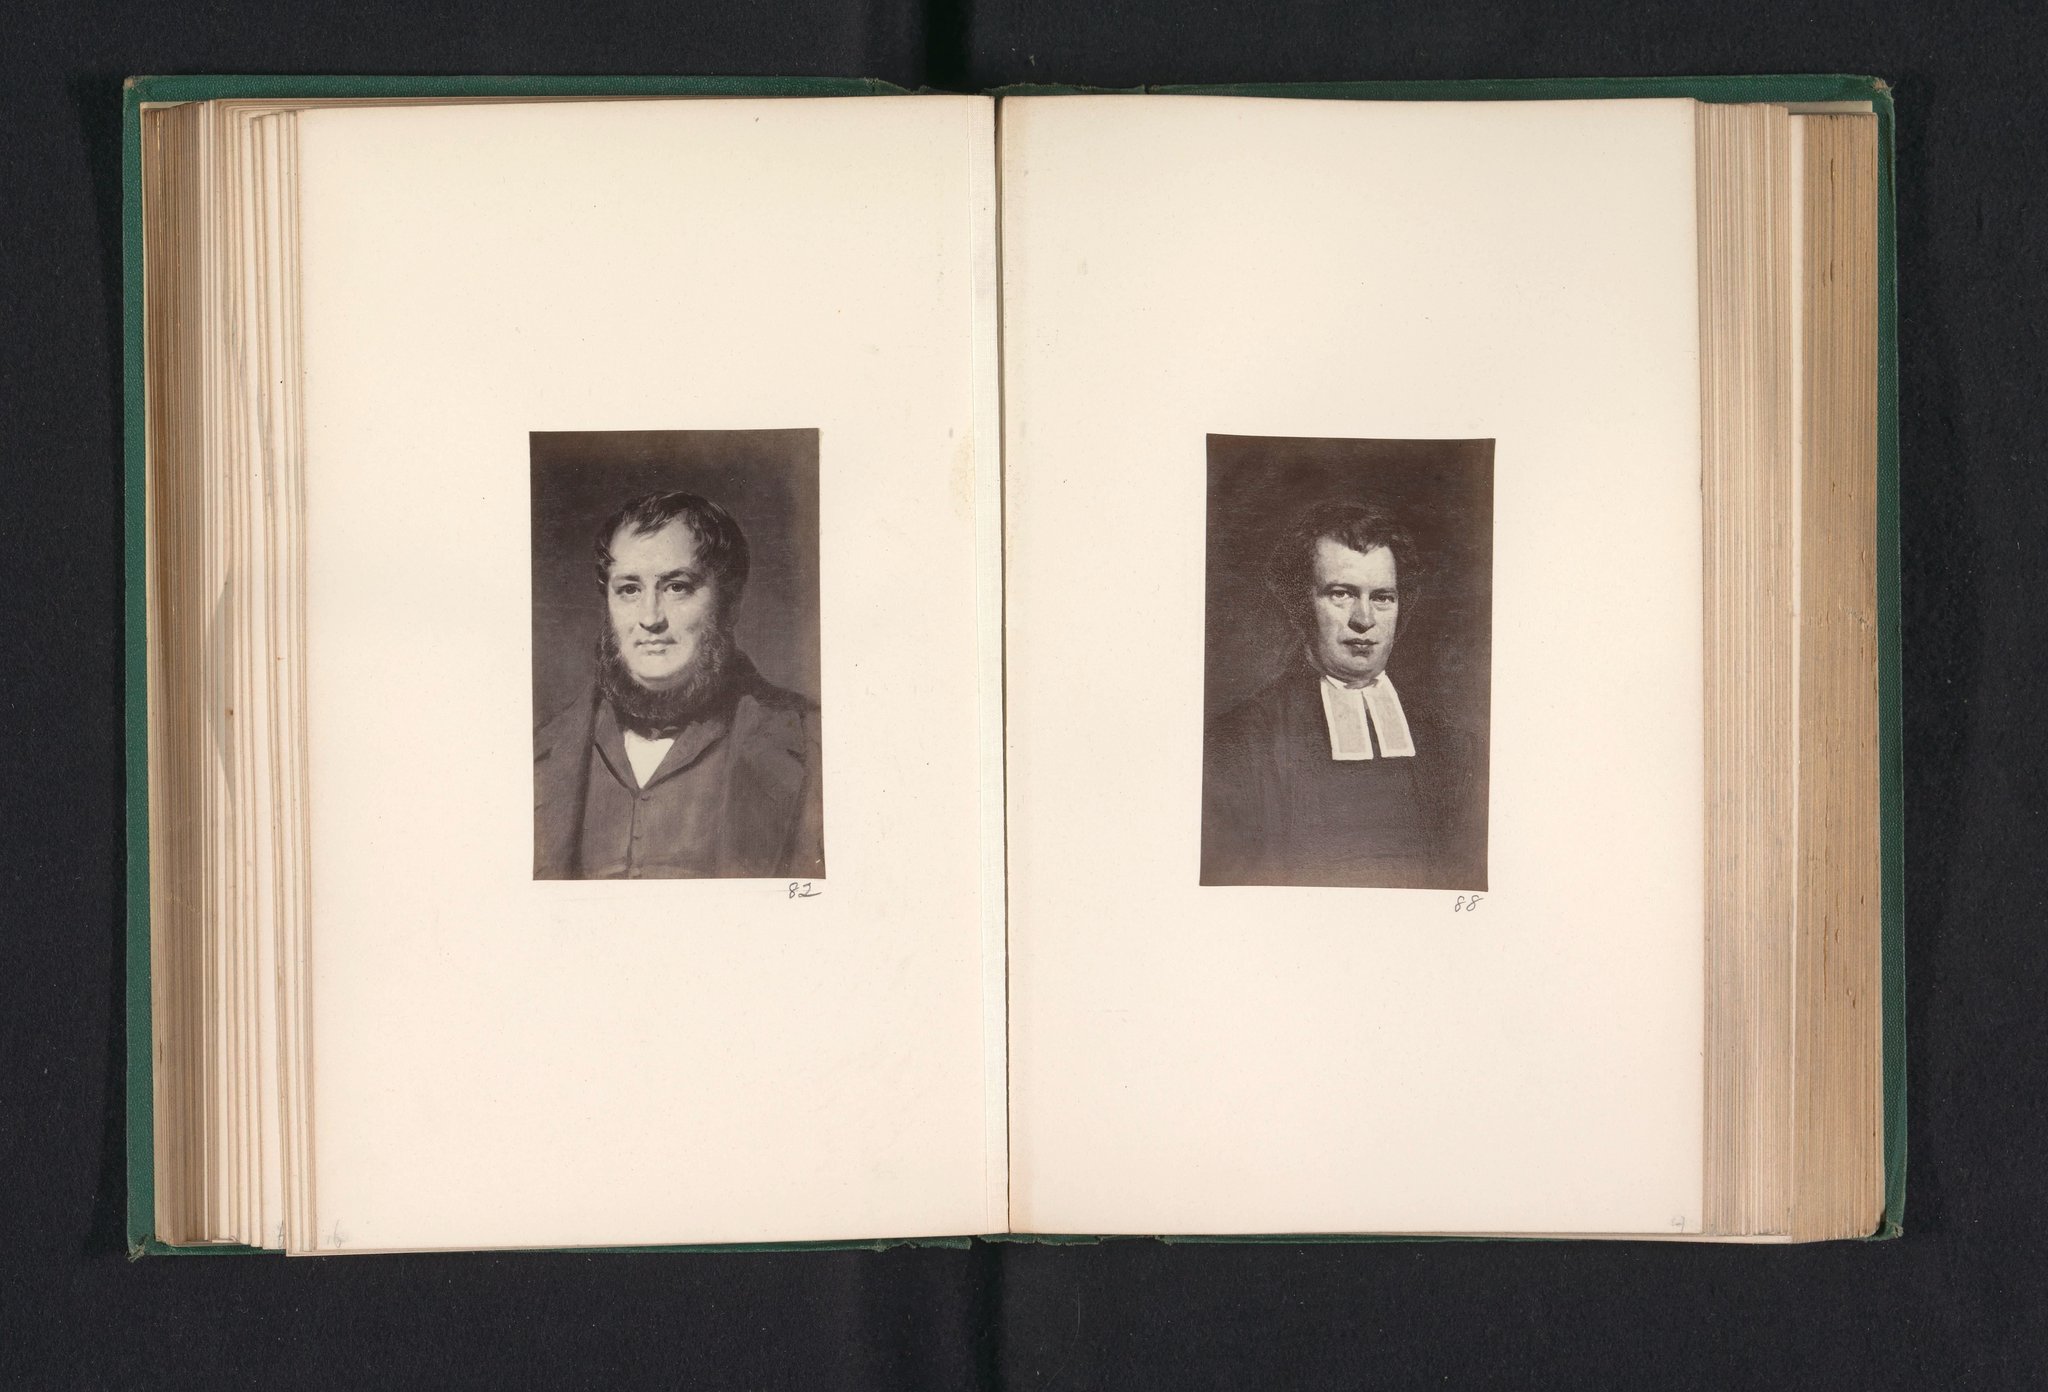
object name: reproduction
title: Fotoreproductie van een schilderij, voorstellende een portret van Robert Baird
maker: thomas annan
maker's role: fotograaf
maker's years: 1829-1887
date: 1863-1868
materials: photographic support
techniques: albumen print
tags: historical persons (portraits and scenes from the life) (+ (full) bust portrait)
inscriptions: number: ‘82’